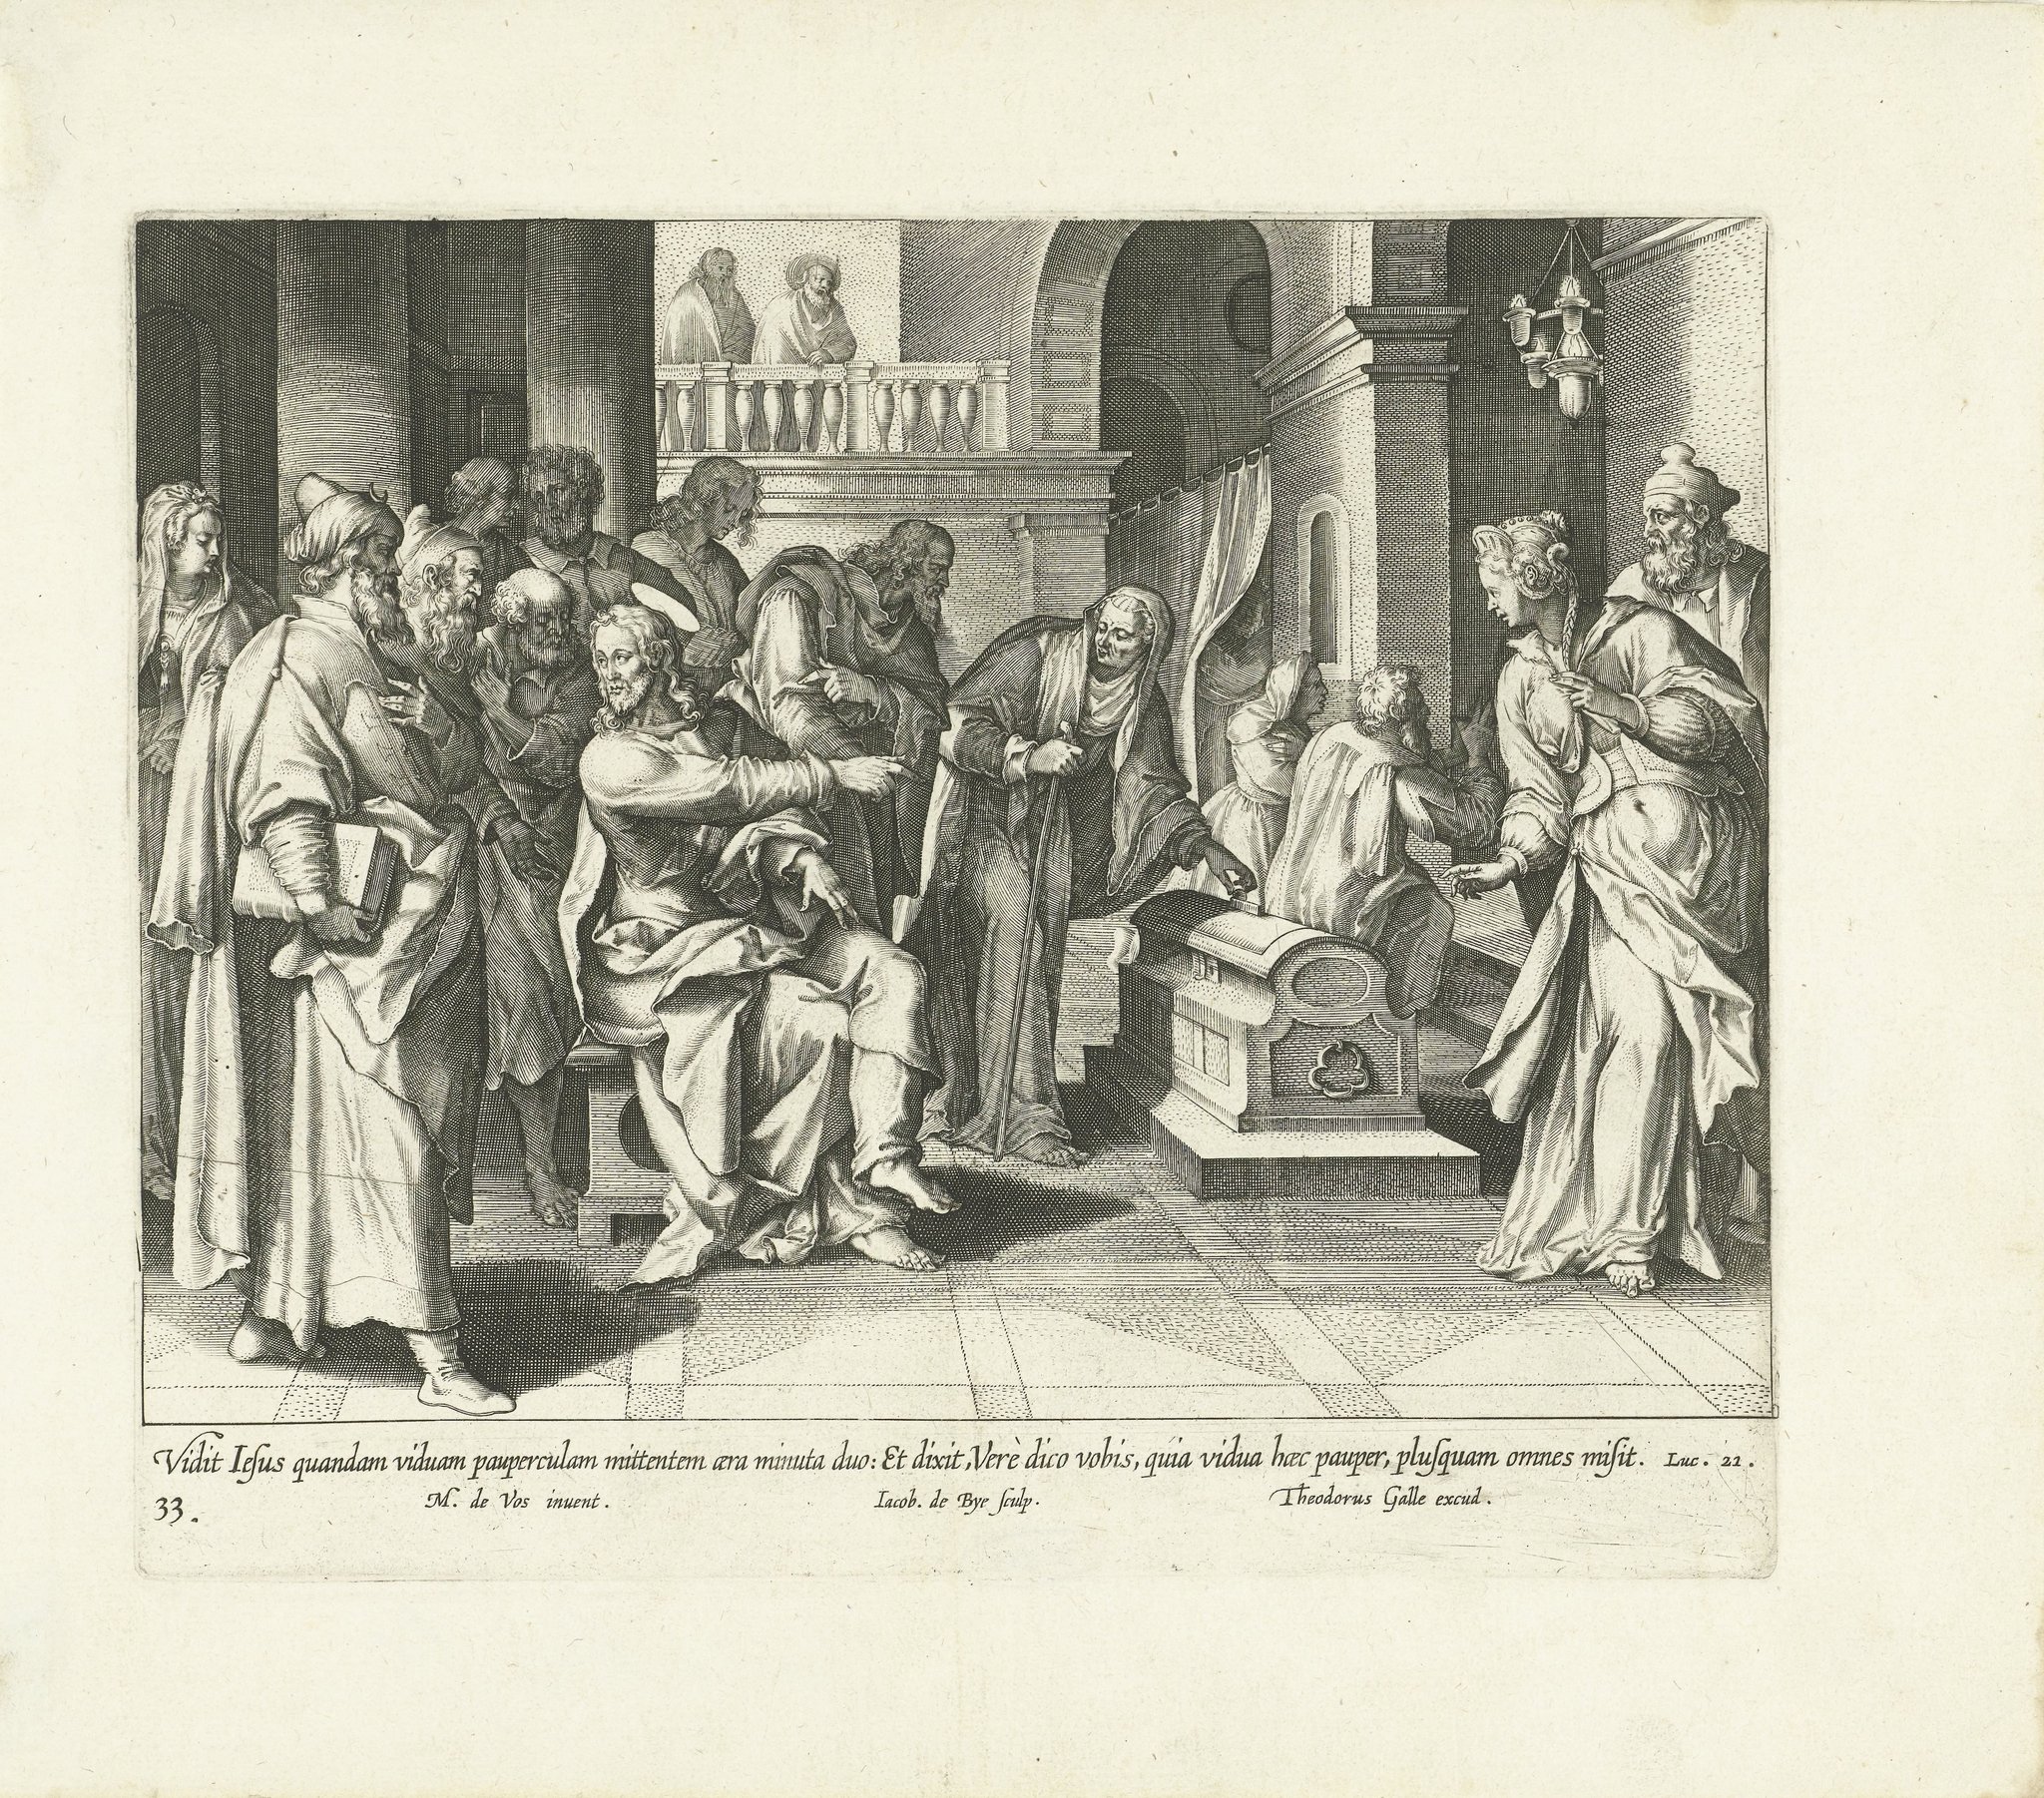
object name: print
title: Leven, passie en wederopstanding van Christus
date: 1598-1618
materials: paper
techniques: engraving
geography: antwerp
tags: the widow's mite: christ draws the disciples' attention to a woman who puts a few coins in the temple's money chest (mark 12:41-44; luke 21:1-4)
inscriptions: collector's mark: Lugt 2228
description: Christus wijst zijn leerlingen op een arme weduwe die wat geld in de offerkist werpt. Deze weduwe heeft meer gegeven dan de grote giften van de rijken omdat zij dat geld niet kan missen (Lucas 21:1-4). De prent heeft een Latijns onderschrift. De prent maakt deel uit van een serie over het leven van Christus.